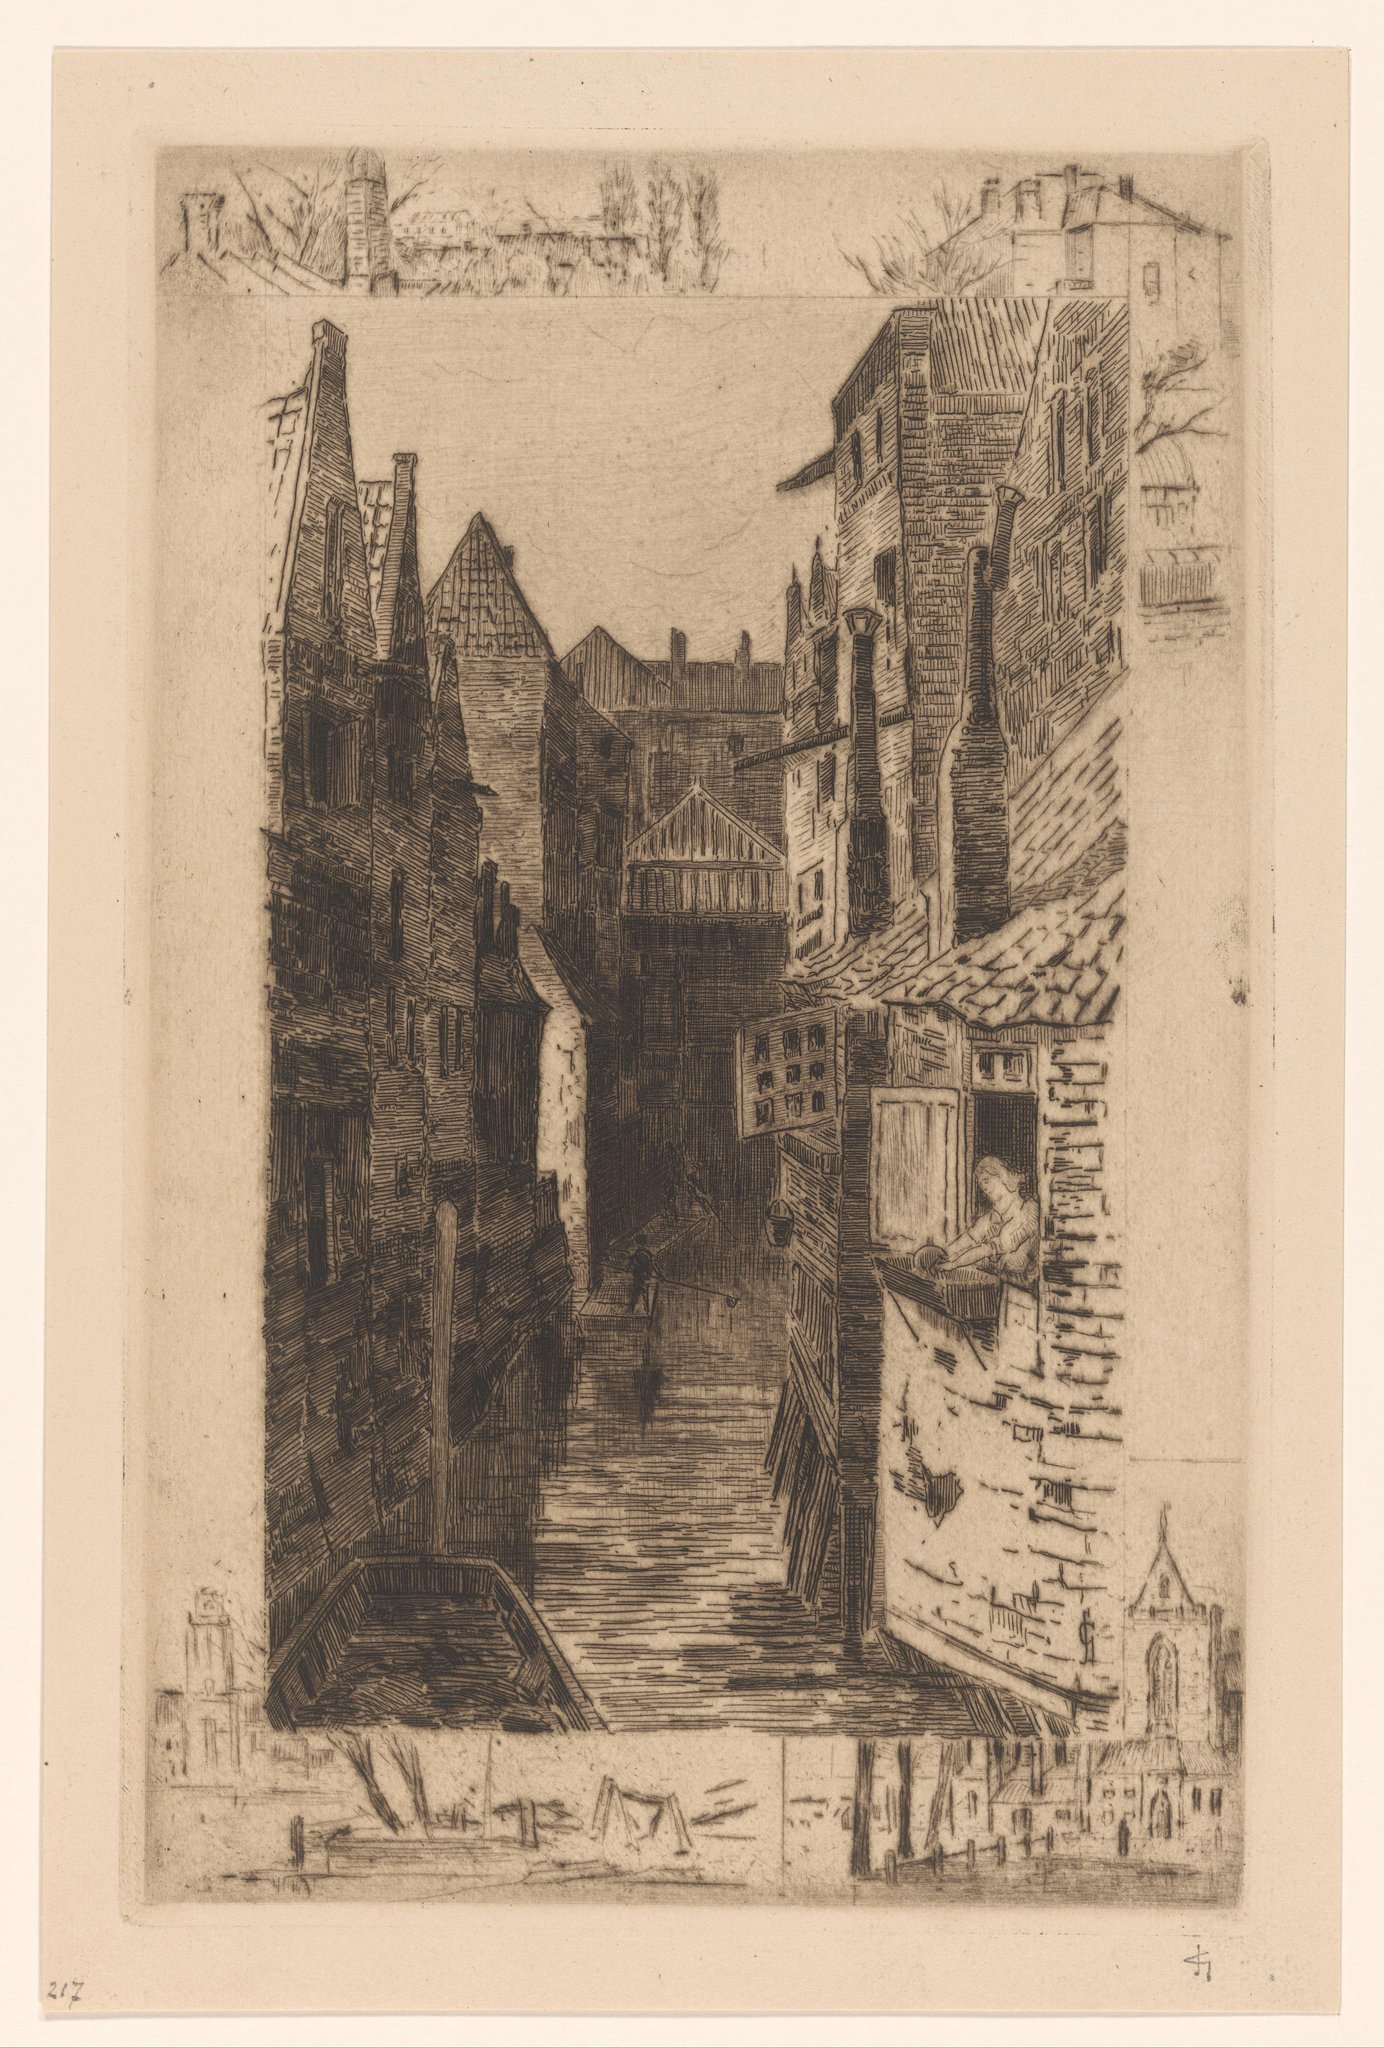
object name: print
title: Gracht in Dordrecht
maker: carel nicolaas storm van s-gravesande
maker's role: draughtsman, print maker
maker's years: 1841-1924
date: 1884-1887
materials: paper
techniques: drypoint, etching, intaglio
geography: netherlands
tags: washing up, canals, waters (in city) (+ city(-scape) with figures, staffage), dordrecht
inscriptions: collector's mark: Lugt 2228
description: Gezicht op een gracht waarin schuiten varen. Op de voorgrond staat een vrouw bij het open raam af te wassen. In de rand rondom de voorstelling vier stadsgezichten.